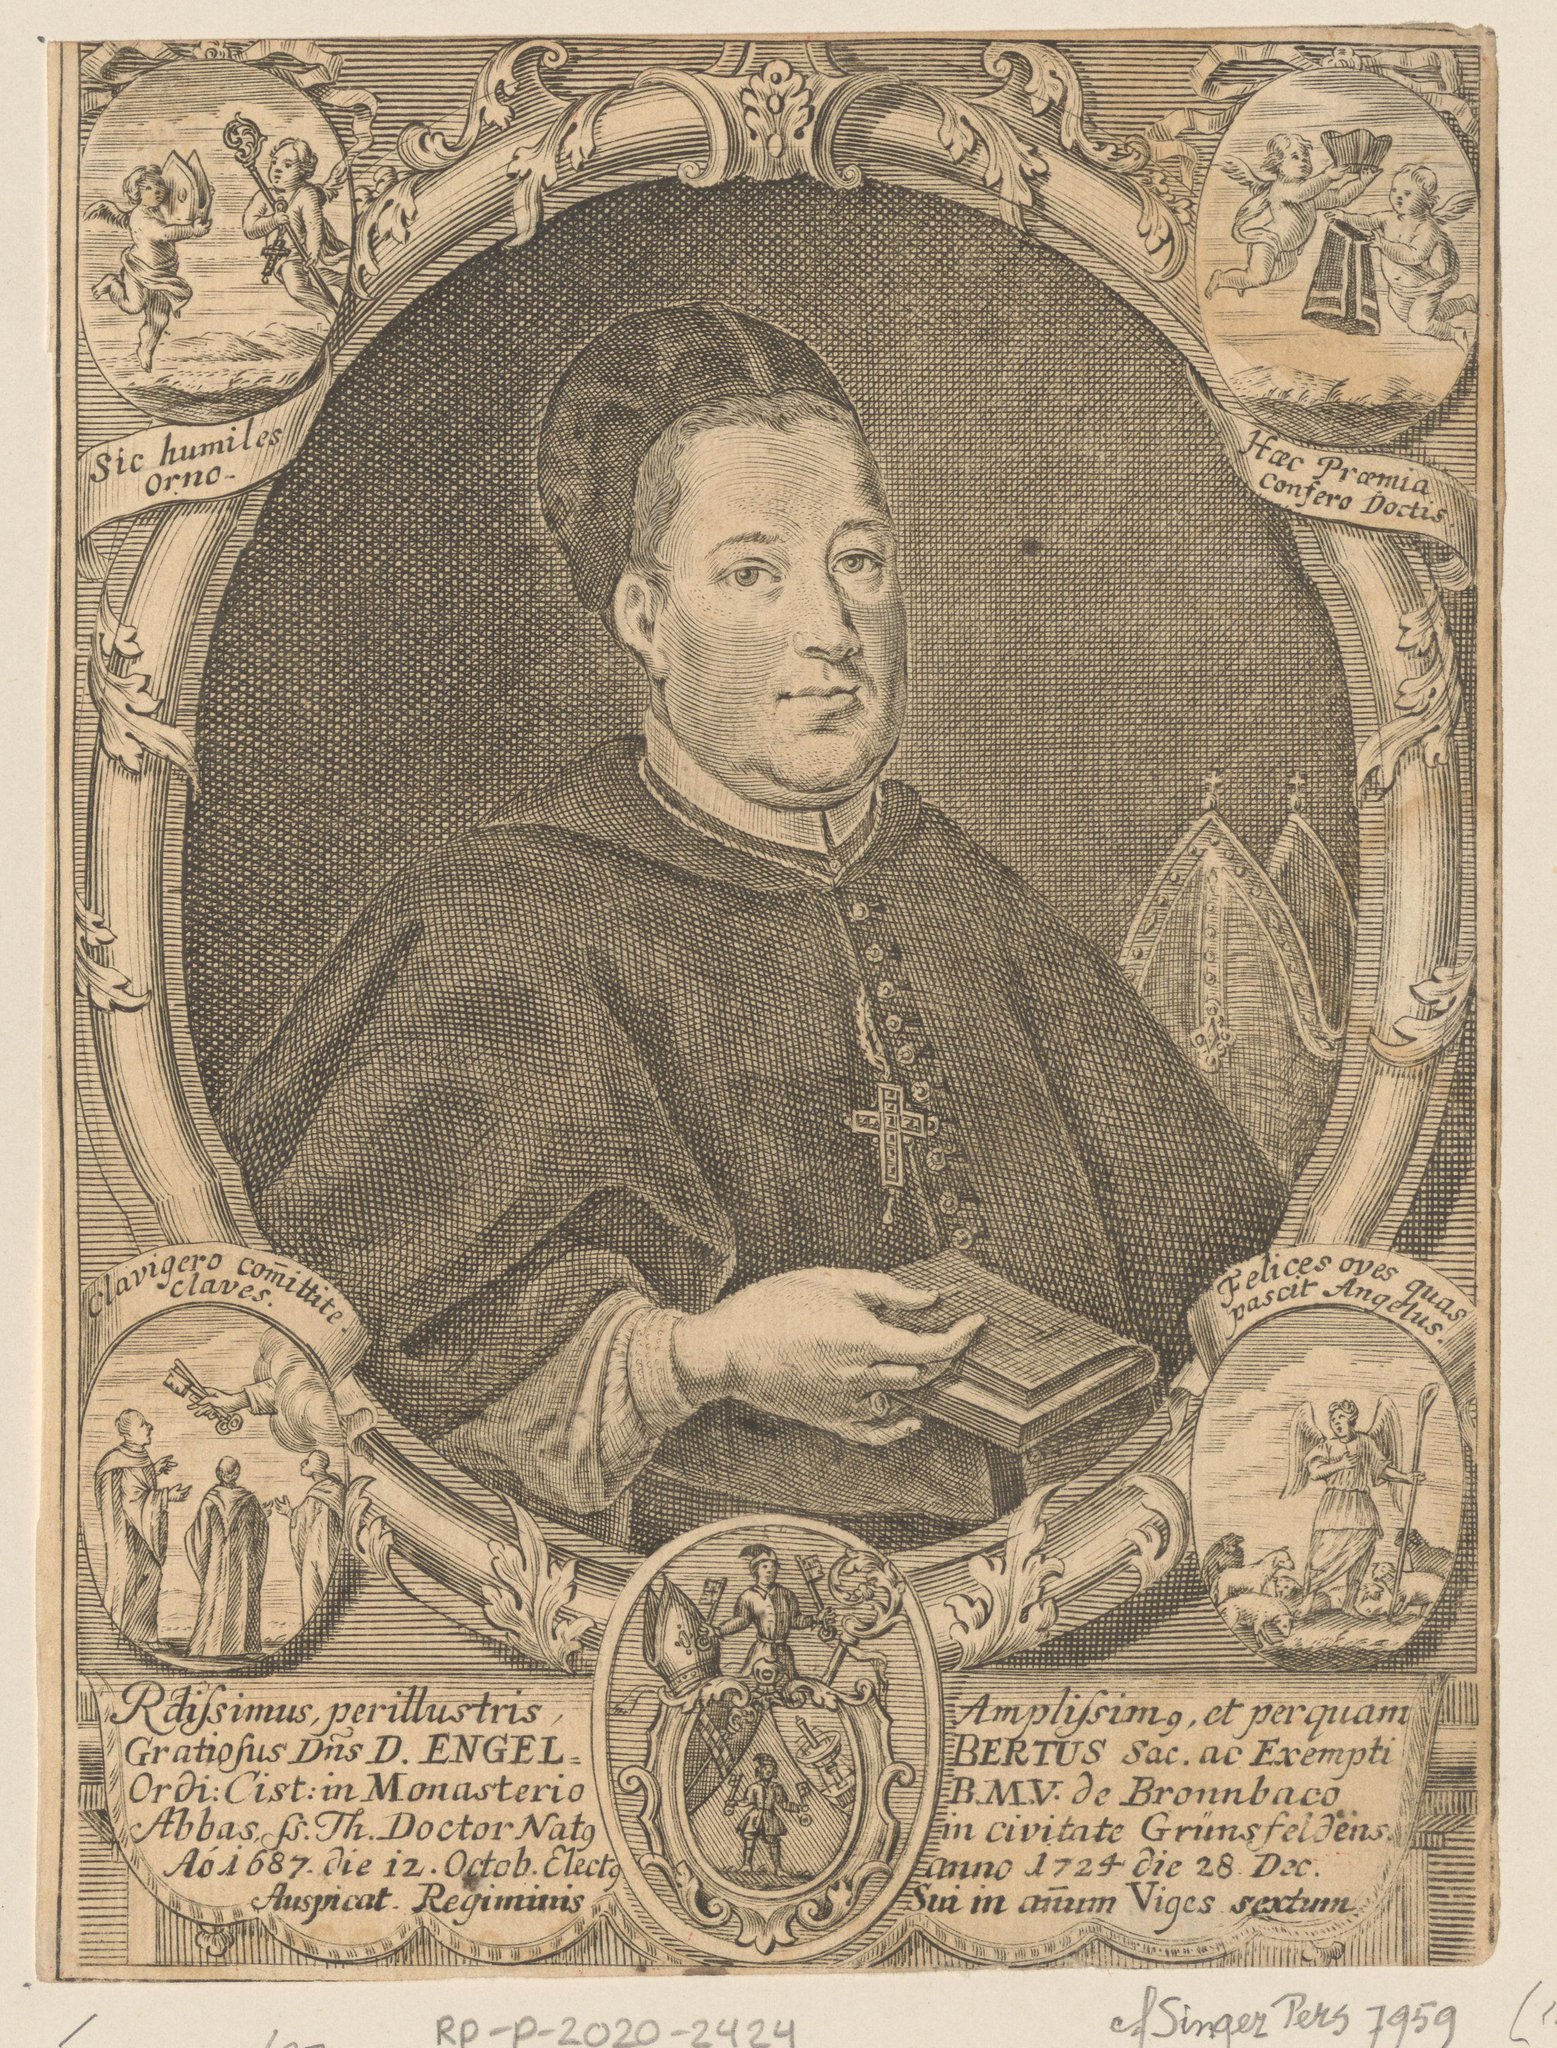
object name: print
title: Portret van Engelbert, abt van Bronnbach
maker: Anonymous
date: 1724-1750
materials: paper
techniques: engraving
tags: abbot, monks and nuns, historical persons, key, cupids: 'amores', 'amoretti', 'putti', angels